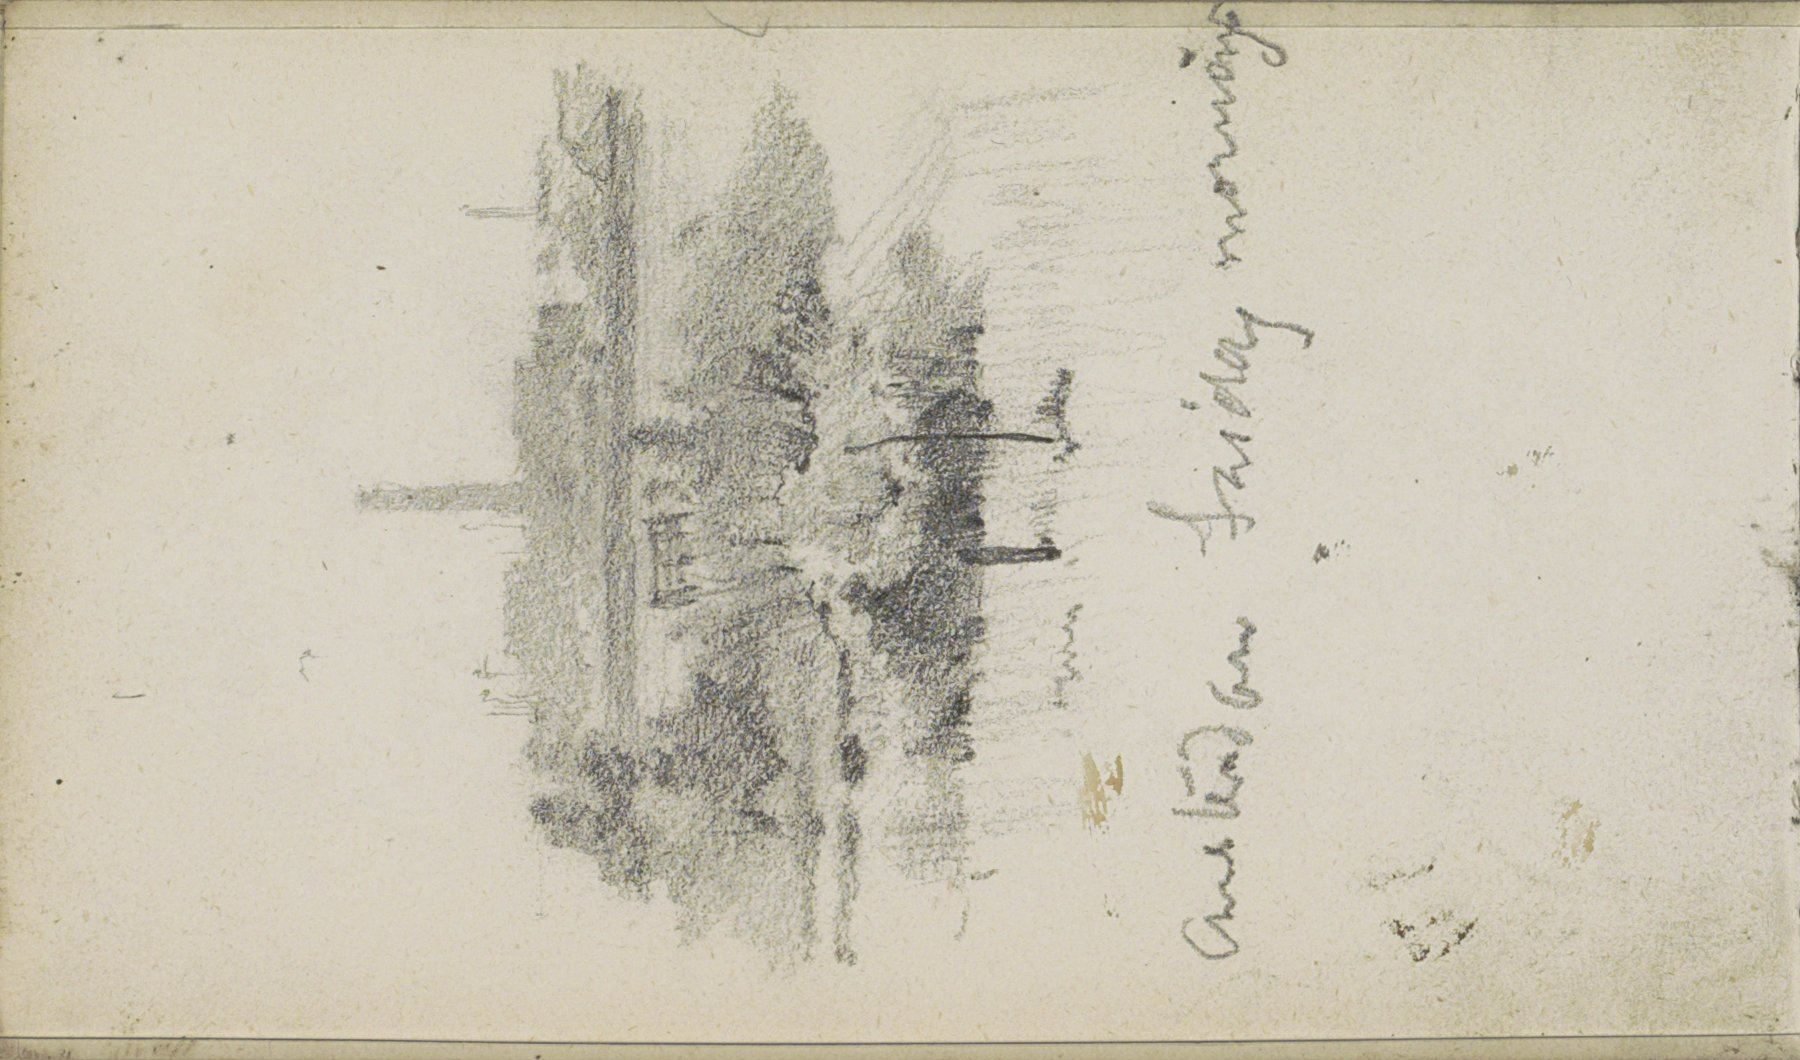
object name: sketchbook leaf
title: Gezicht op Amsterdam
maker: george clausen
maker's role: draughtsman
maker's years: 1852-1912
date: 1875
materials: paper, pencil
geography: amsterdam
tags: city-view, and landscape with man-made constructions, amsterdam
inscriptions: annotation: ‘amsterdam friday morning’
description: Blad 19 verso uit een schetsboek met 46 bladen.